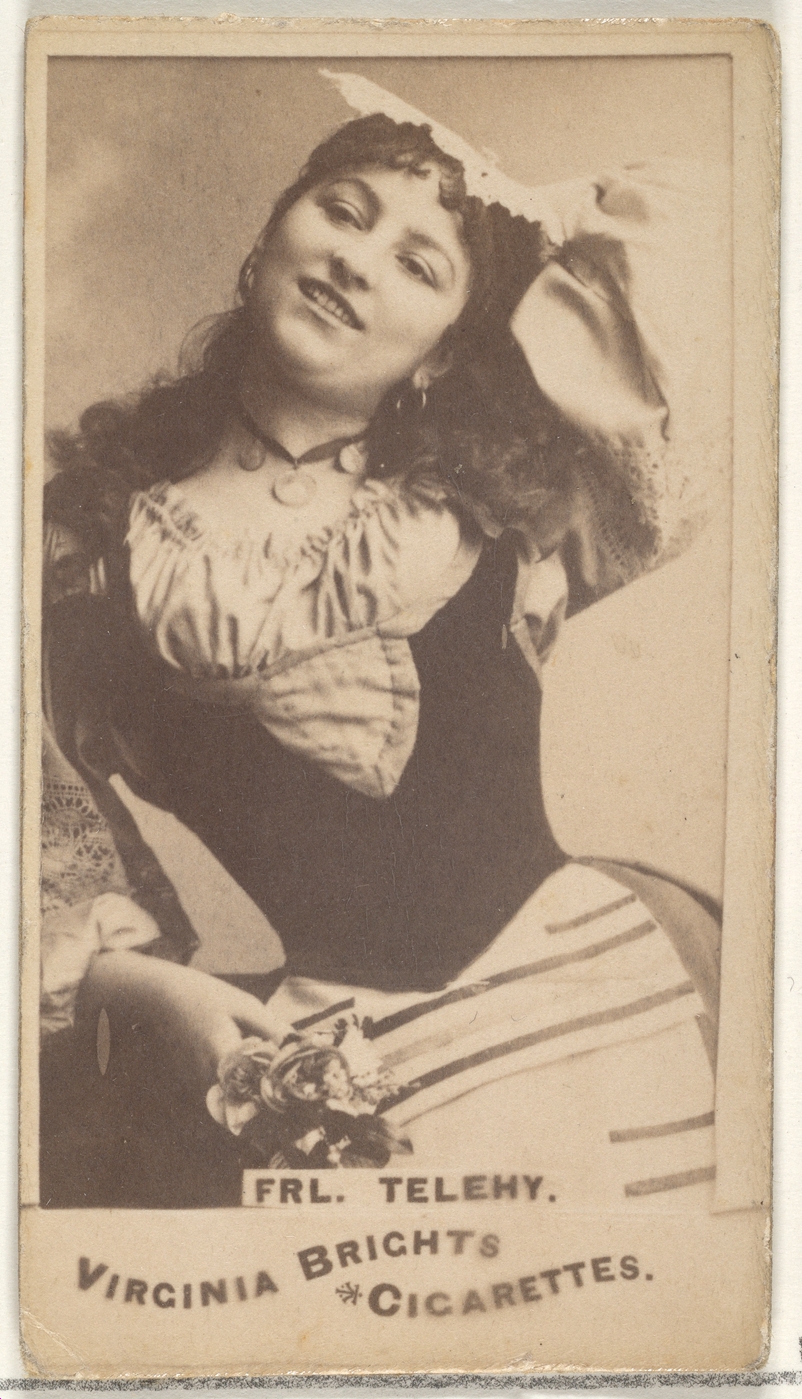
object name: photograph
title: Fräulein Telehy, from the Actors and Actresses series (N45, Type 1) for Virginia Brights Cigarettes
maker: allen & ginter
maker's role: publisher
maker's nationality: american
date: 1888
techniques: albumen silver print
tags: portraits,women,actresses